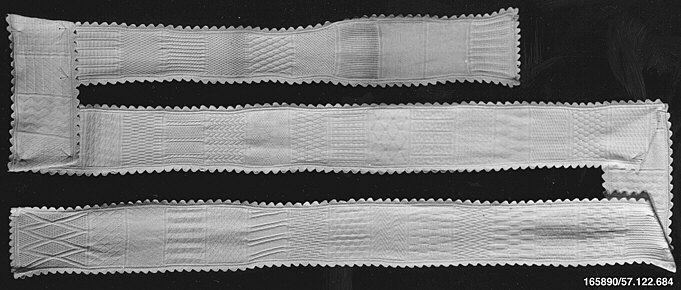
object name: sampler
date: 1801-1900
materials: wool